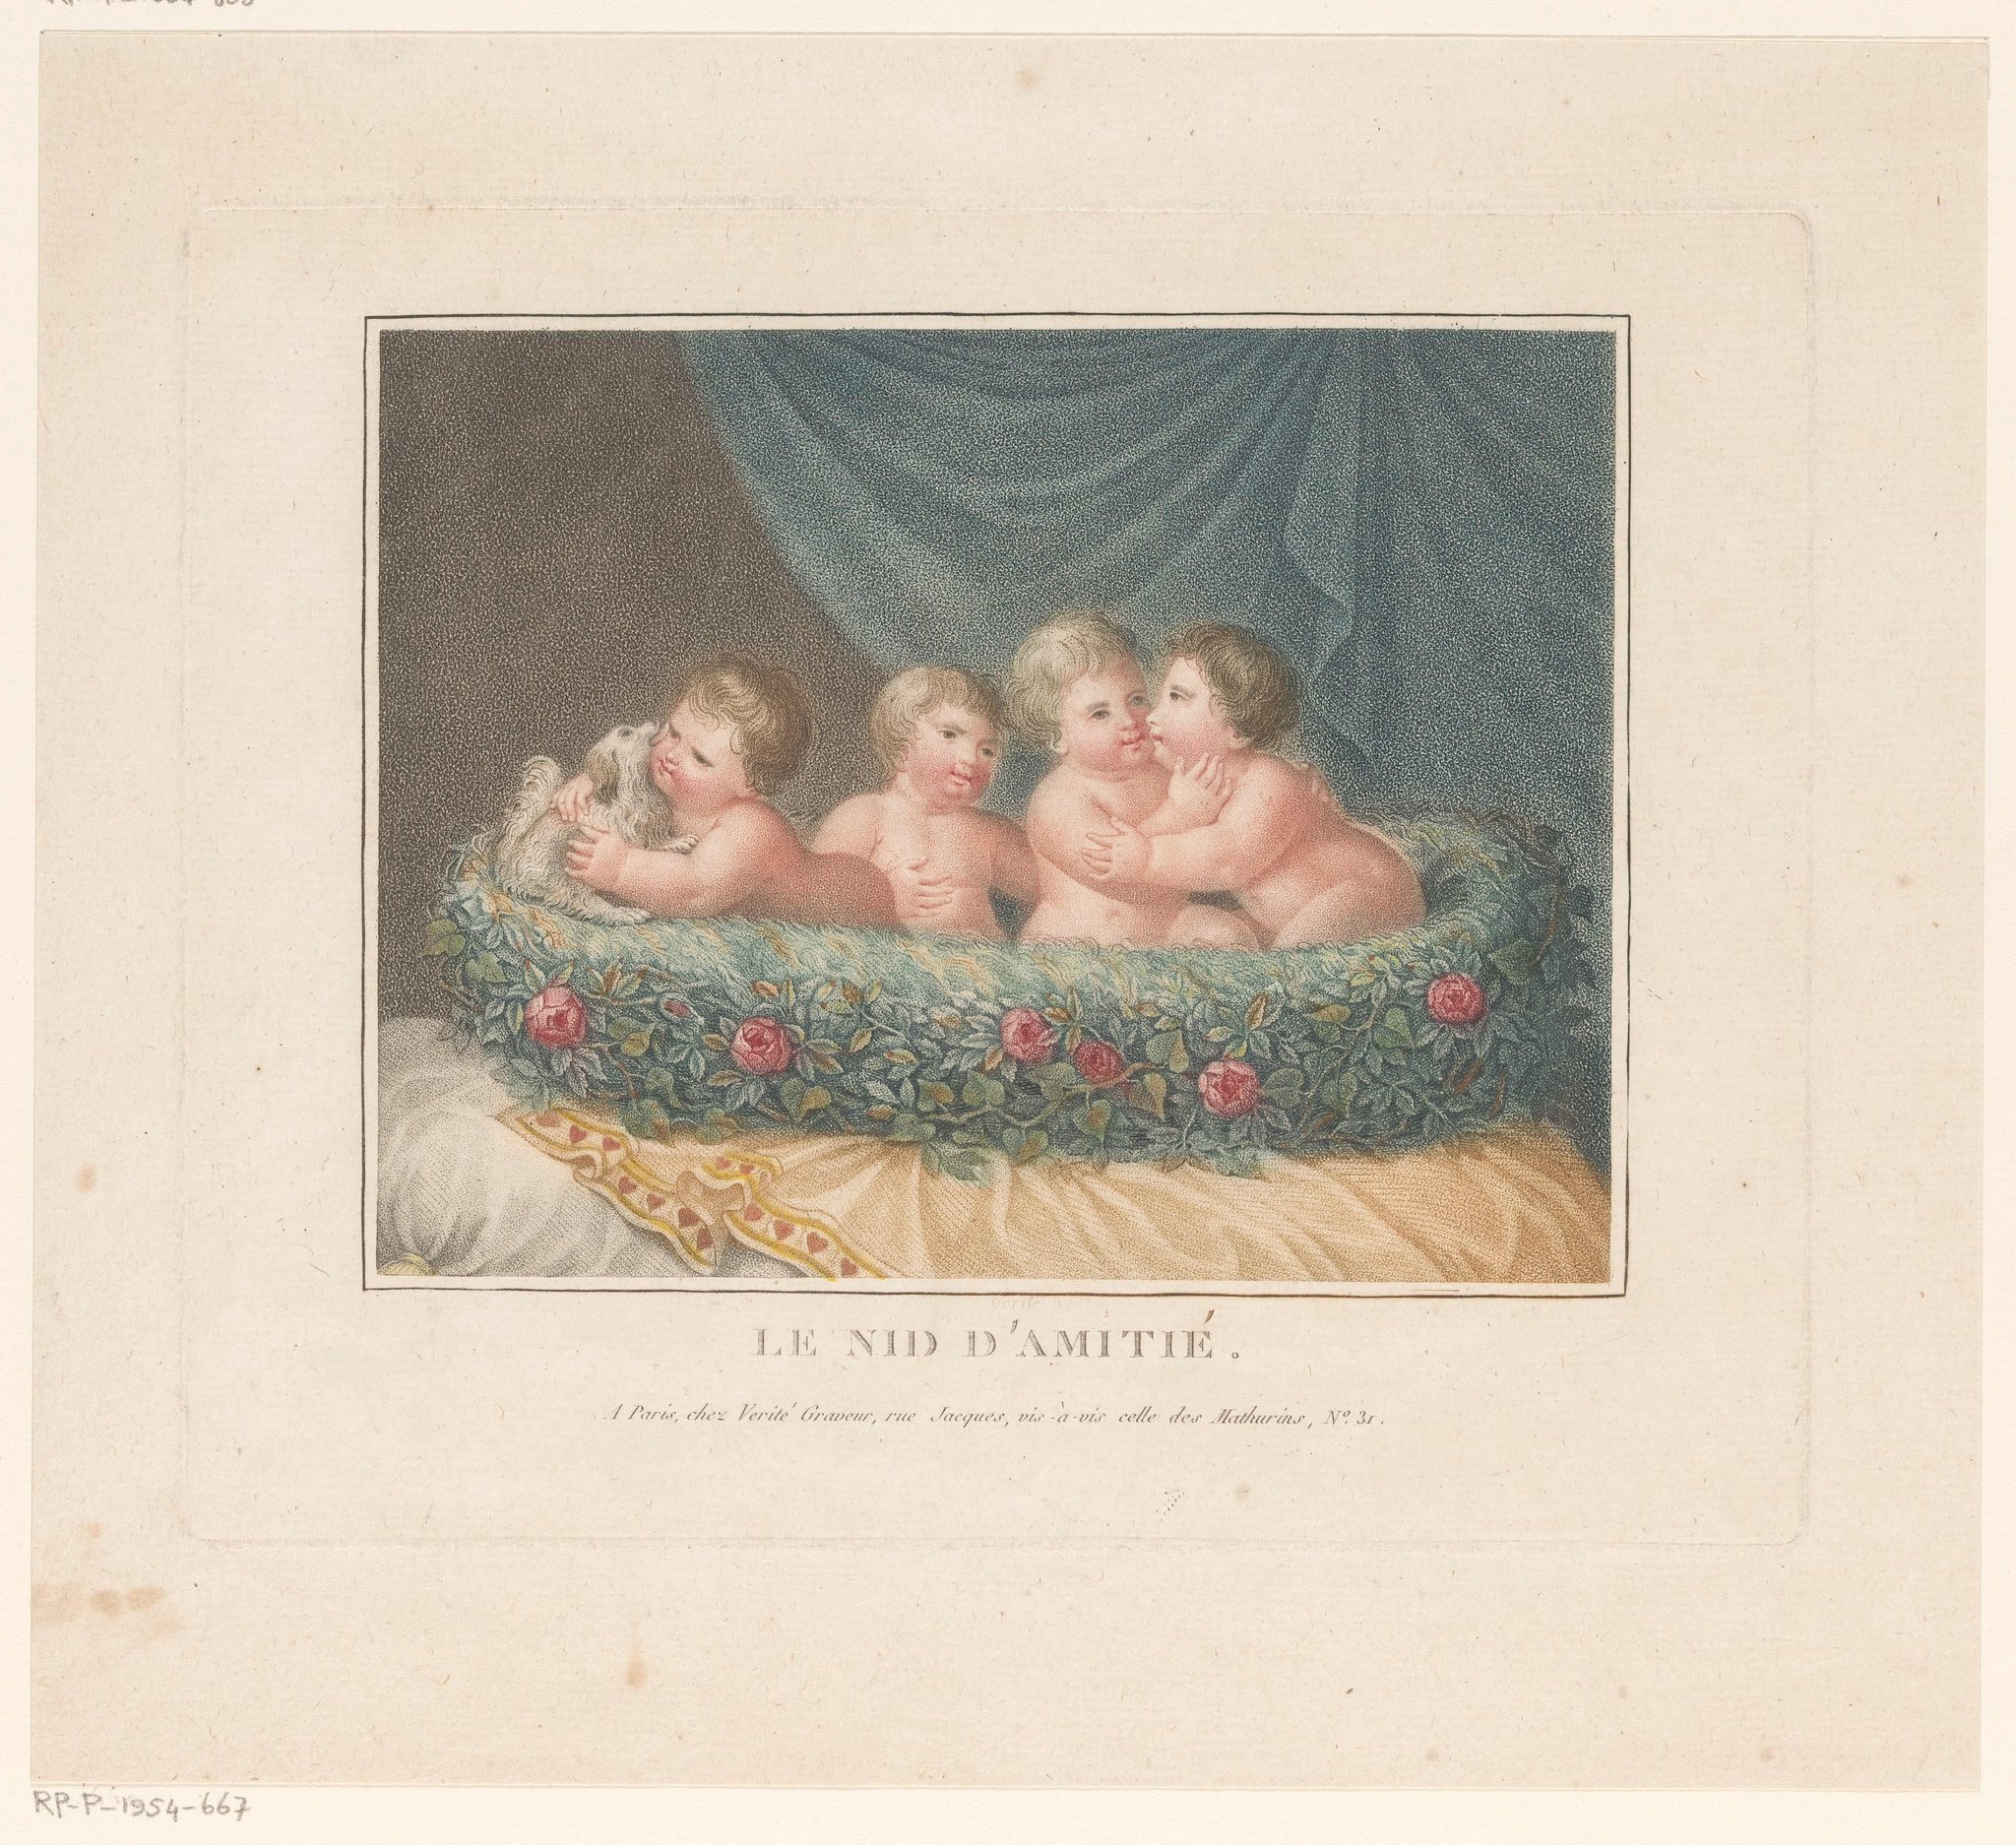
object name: print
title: Le Nid d'Amitié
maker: jean baptiste vérité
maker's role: print maker, publisher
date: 1788-1805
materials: paper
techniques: printing, engraving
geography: france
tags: flowers: rose, cupids: 'amores', 'amoretti', 'putti', dog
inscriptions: collector's mark: Lugt 2760, collector's mark: Lugt 2228